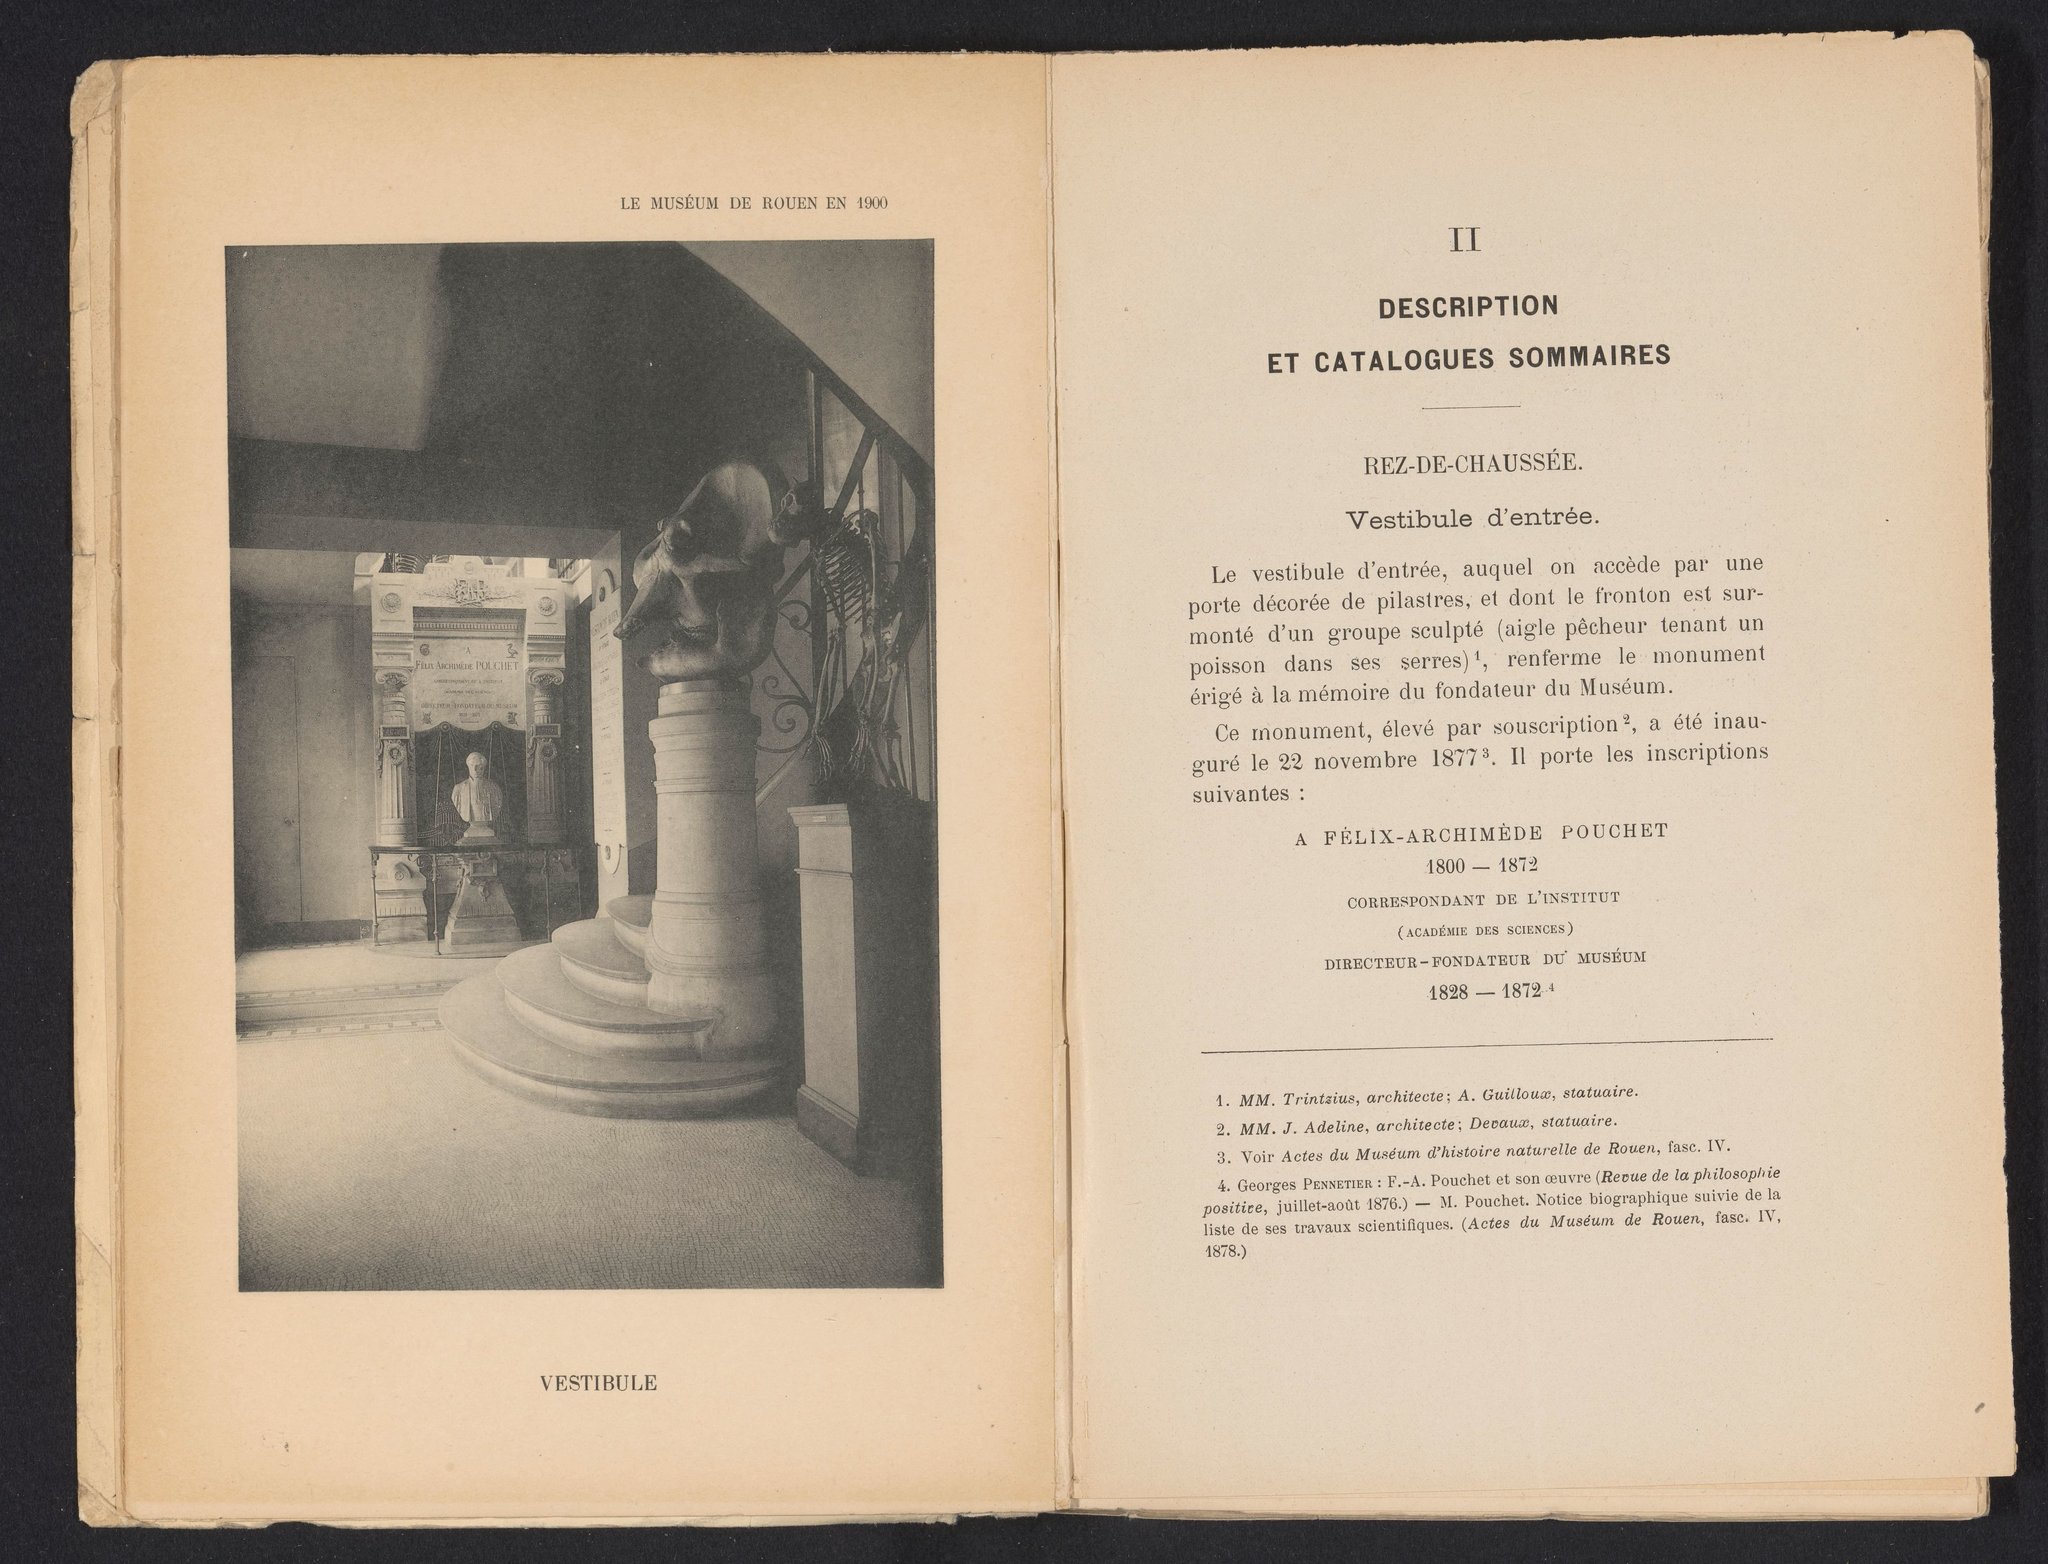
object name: page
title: Vestibule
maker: Anonymous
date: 1890-1900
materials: paper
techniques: photograph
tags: vestibule, hall, permanent exhibition, museum